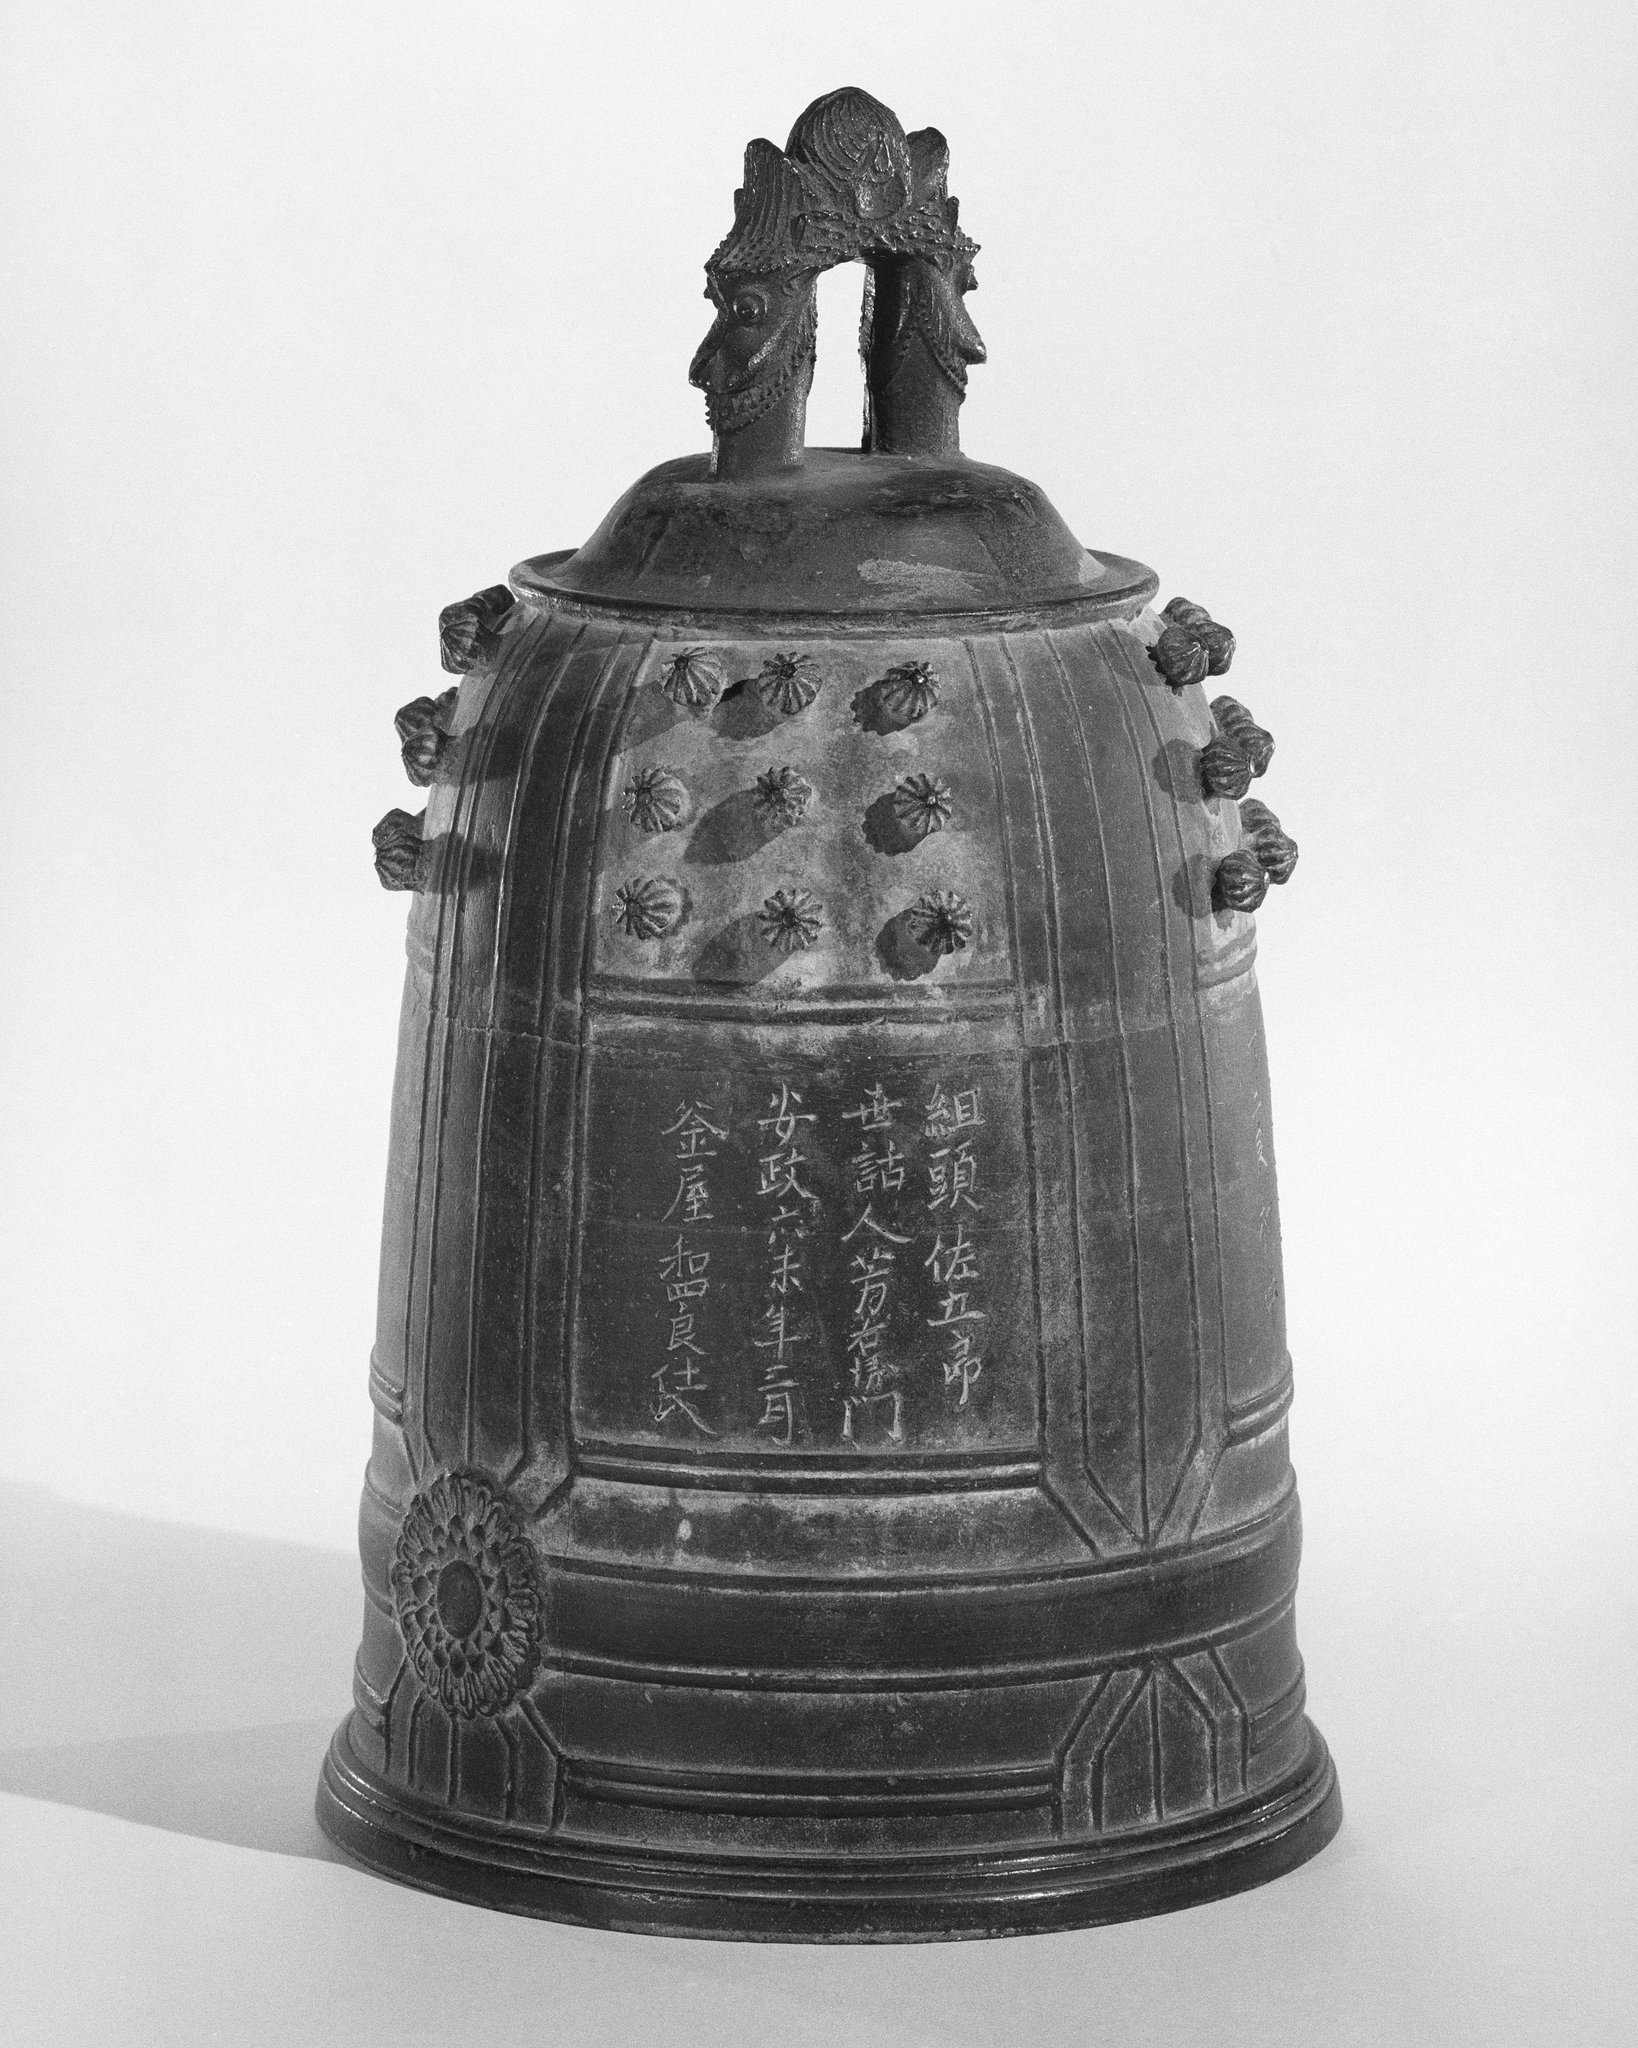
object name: densho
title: Densho (殿鐘)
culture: japanese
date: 1856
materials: bronze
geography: japan